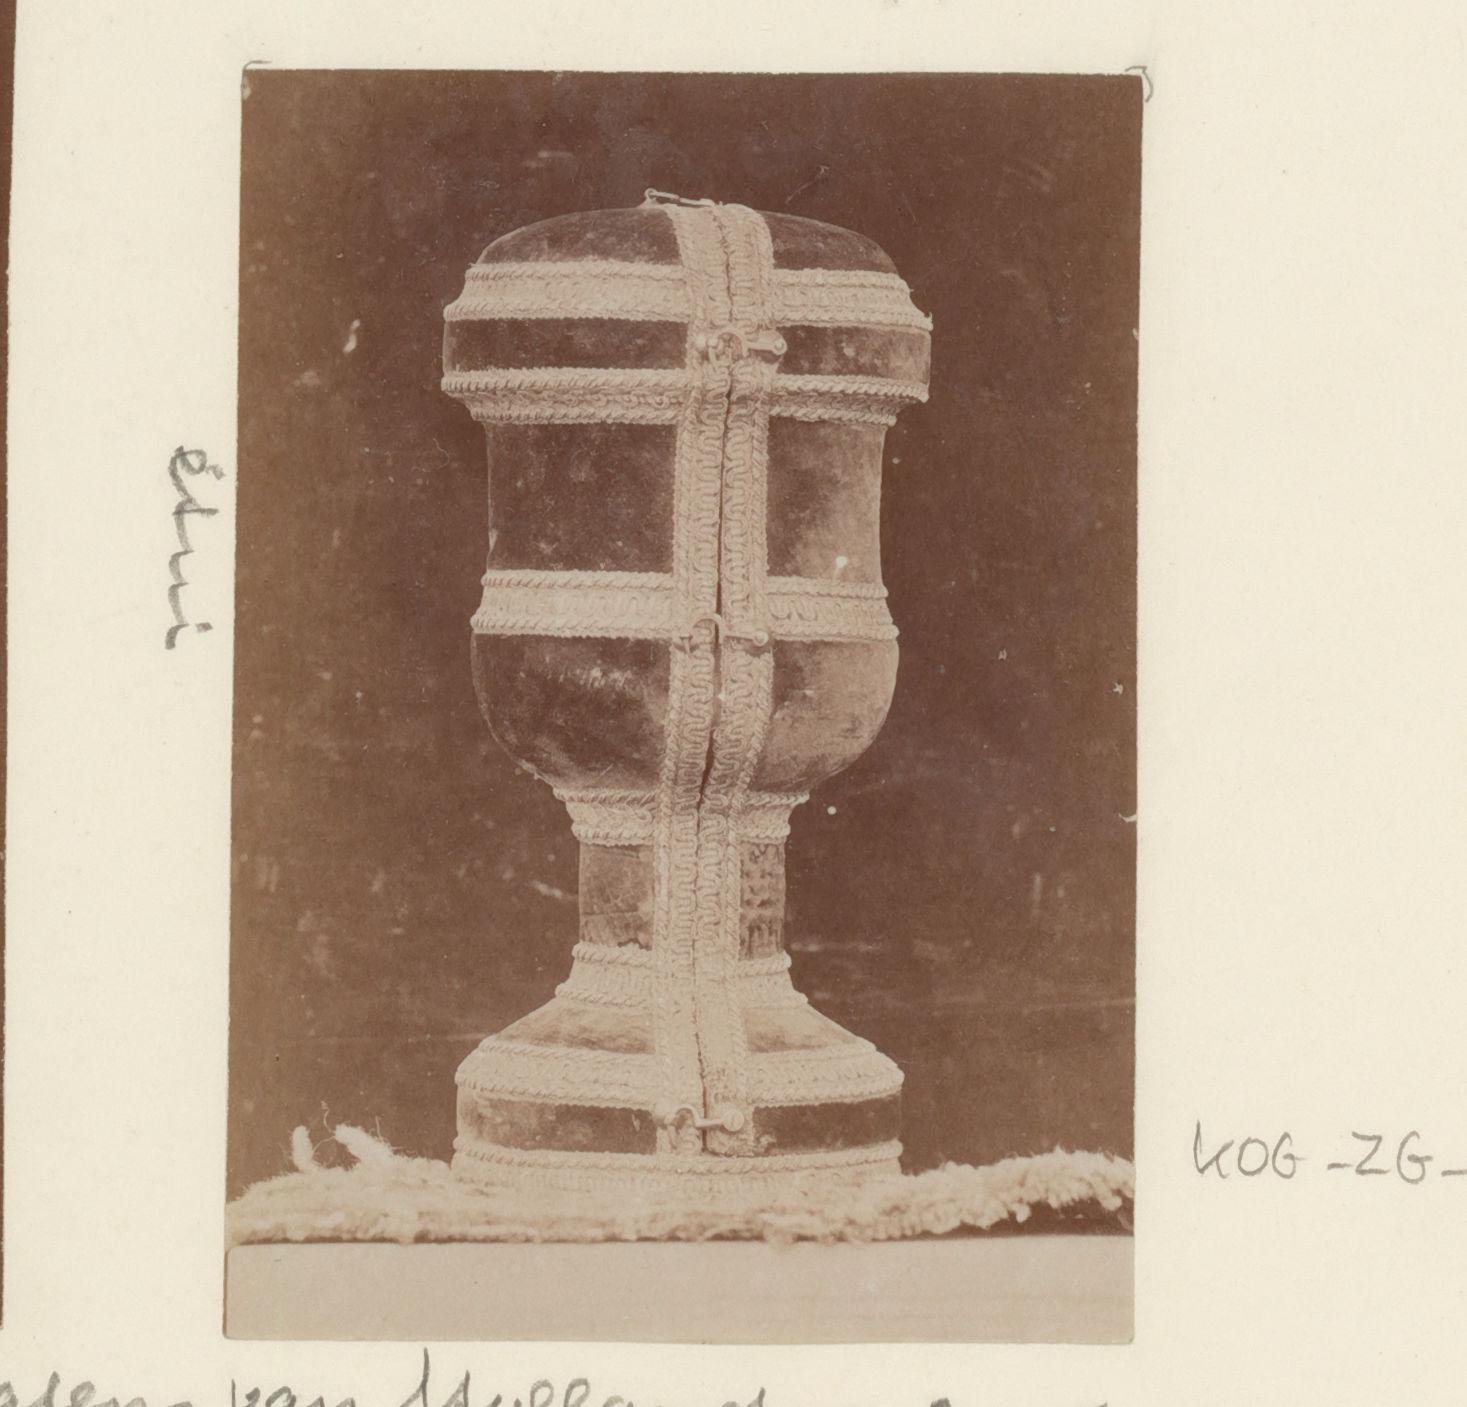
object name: photograph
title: Foedraal voor de Chathambeker van admiraal Michiel Adriaenszoon de Ruyter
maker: Anonymous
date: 1880-1920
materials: photographic support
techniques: albumen print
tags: flushing, michiel adriaenszoon de ruyter, cup, alcoholic drinks, battle (+ sailing-ships), raid on the medway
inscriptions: collector's mark, collector's mark: Lugt 1641